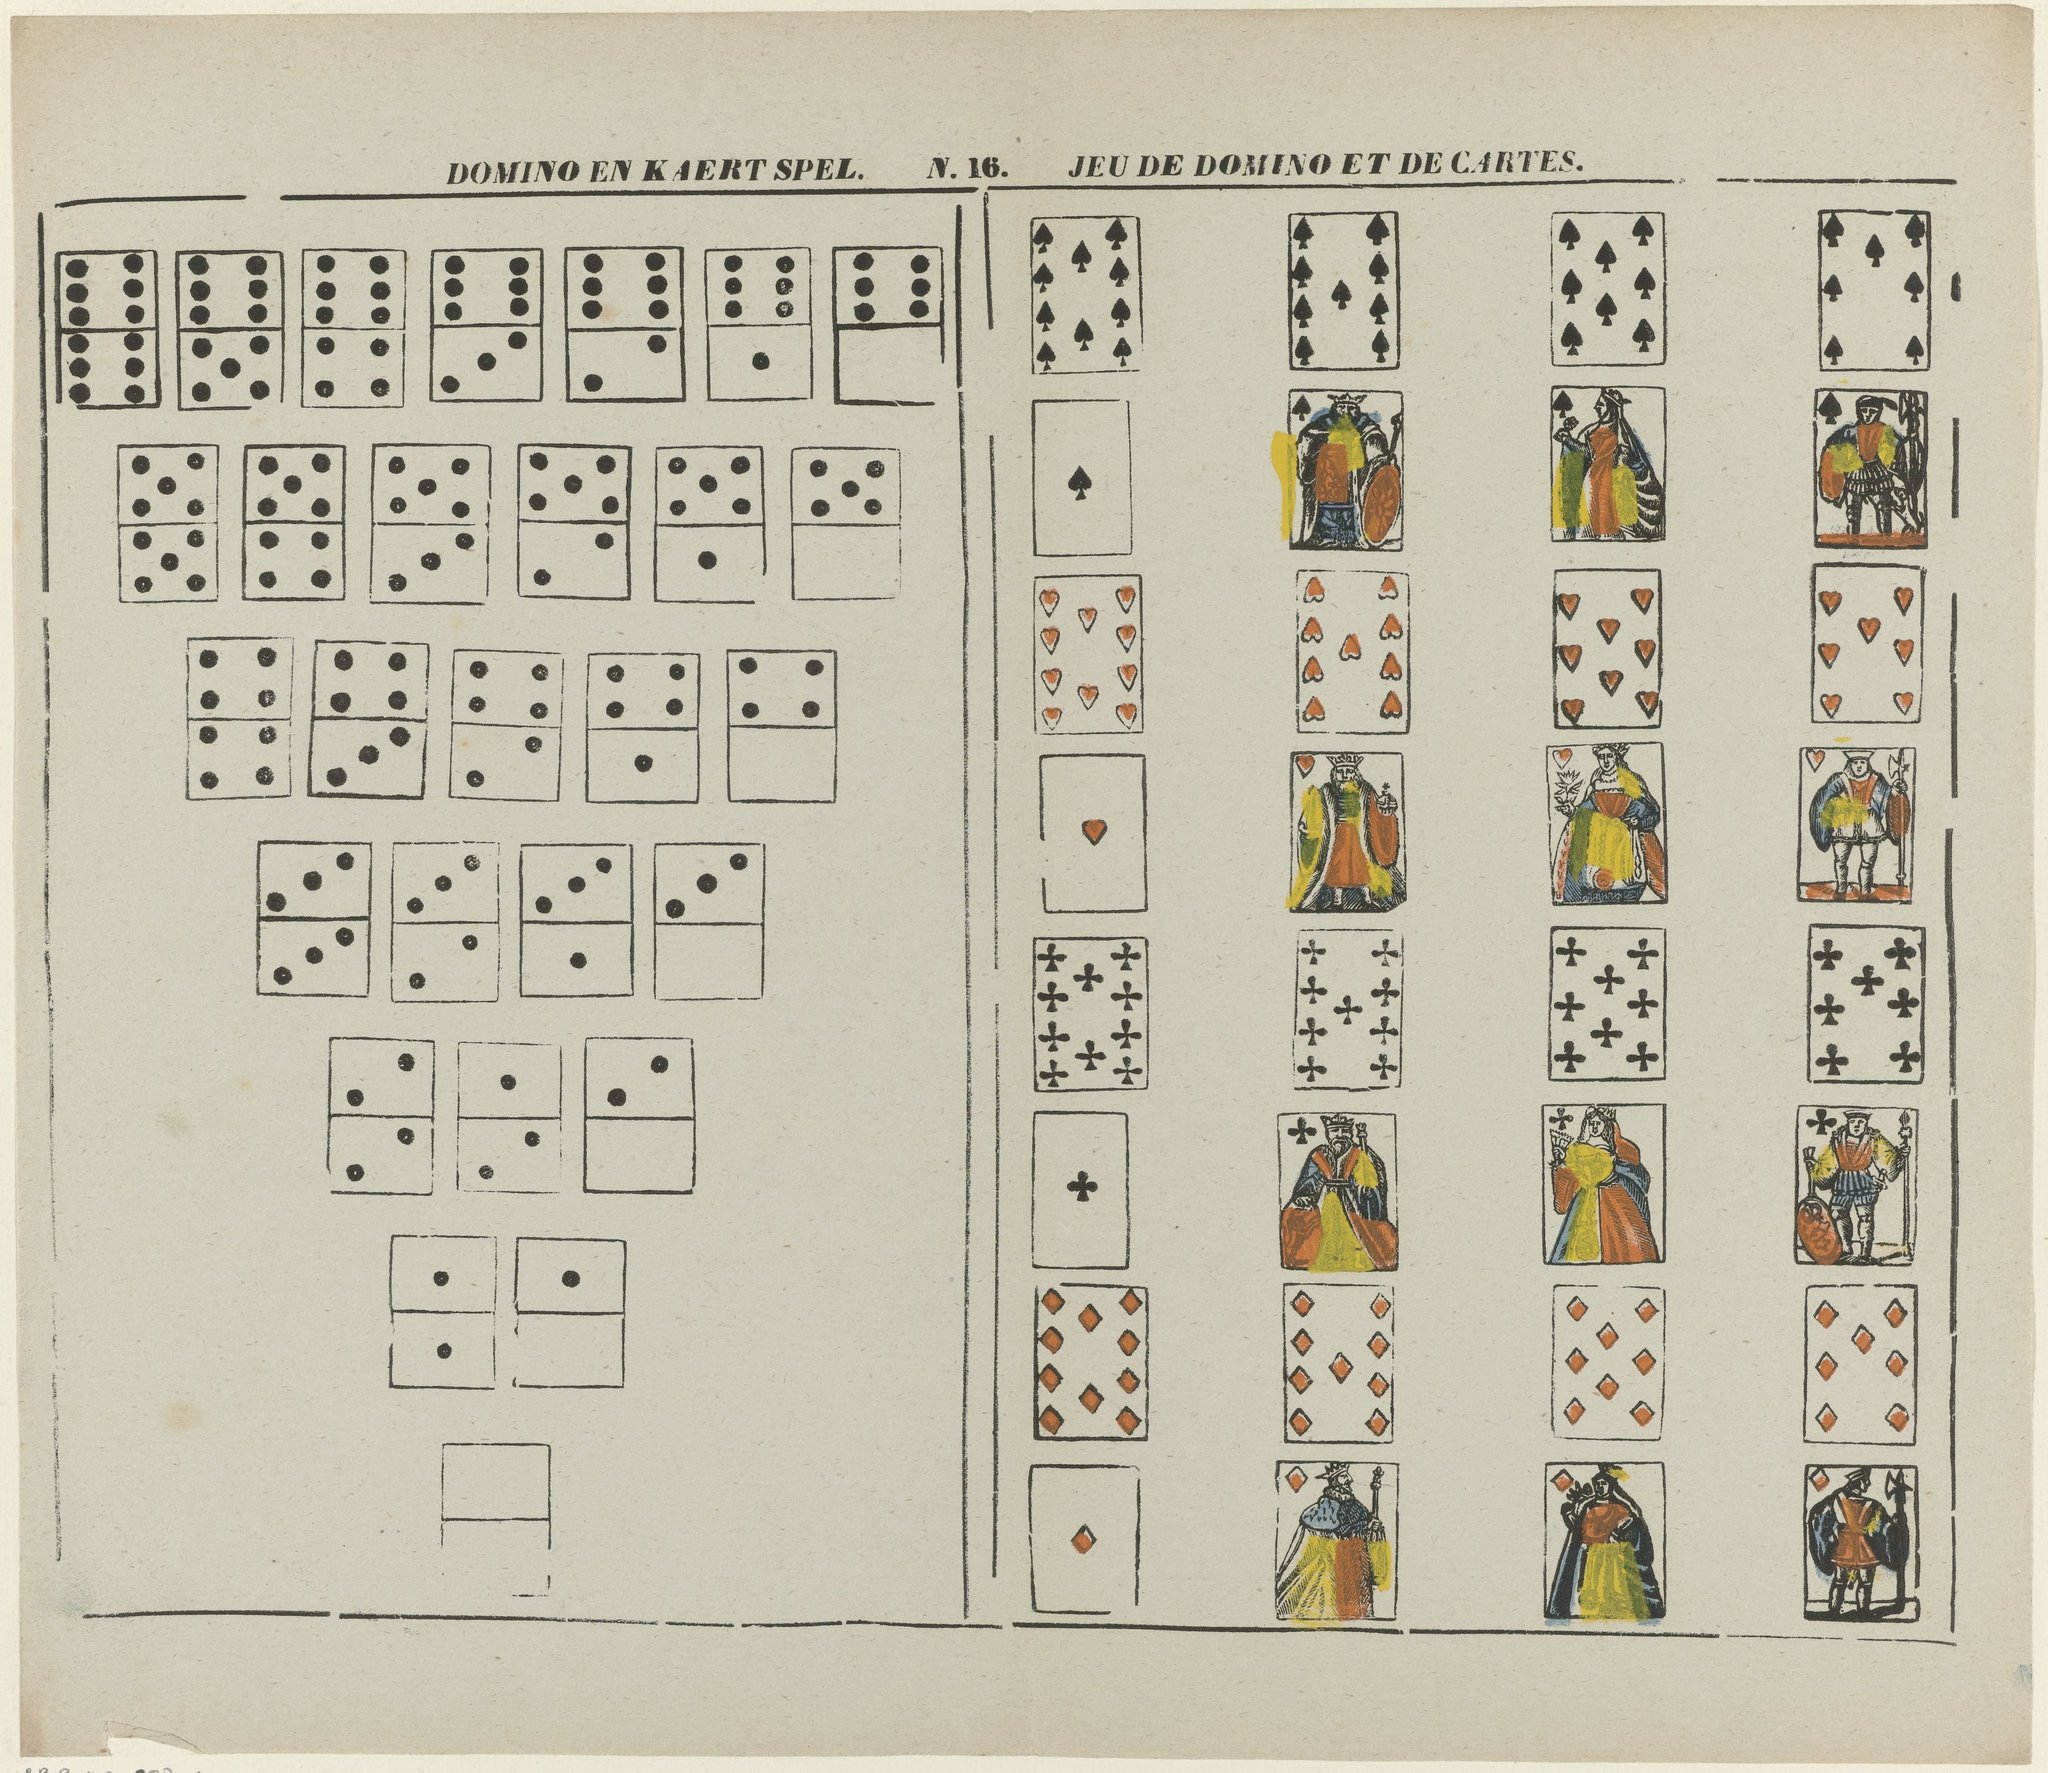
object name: domino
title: Domino en kaert spel / Jeu de domino et de cartes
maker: Anonymous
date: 1833-1900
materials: paper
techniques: colour, letterpress printing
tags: dominoes, playing-cards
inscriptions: collector's mark: Lugt 2760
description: Blad met 32 speelkaarten en 28 dominostenen om uit te knippen. Genummerd midden boven: N 16.